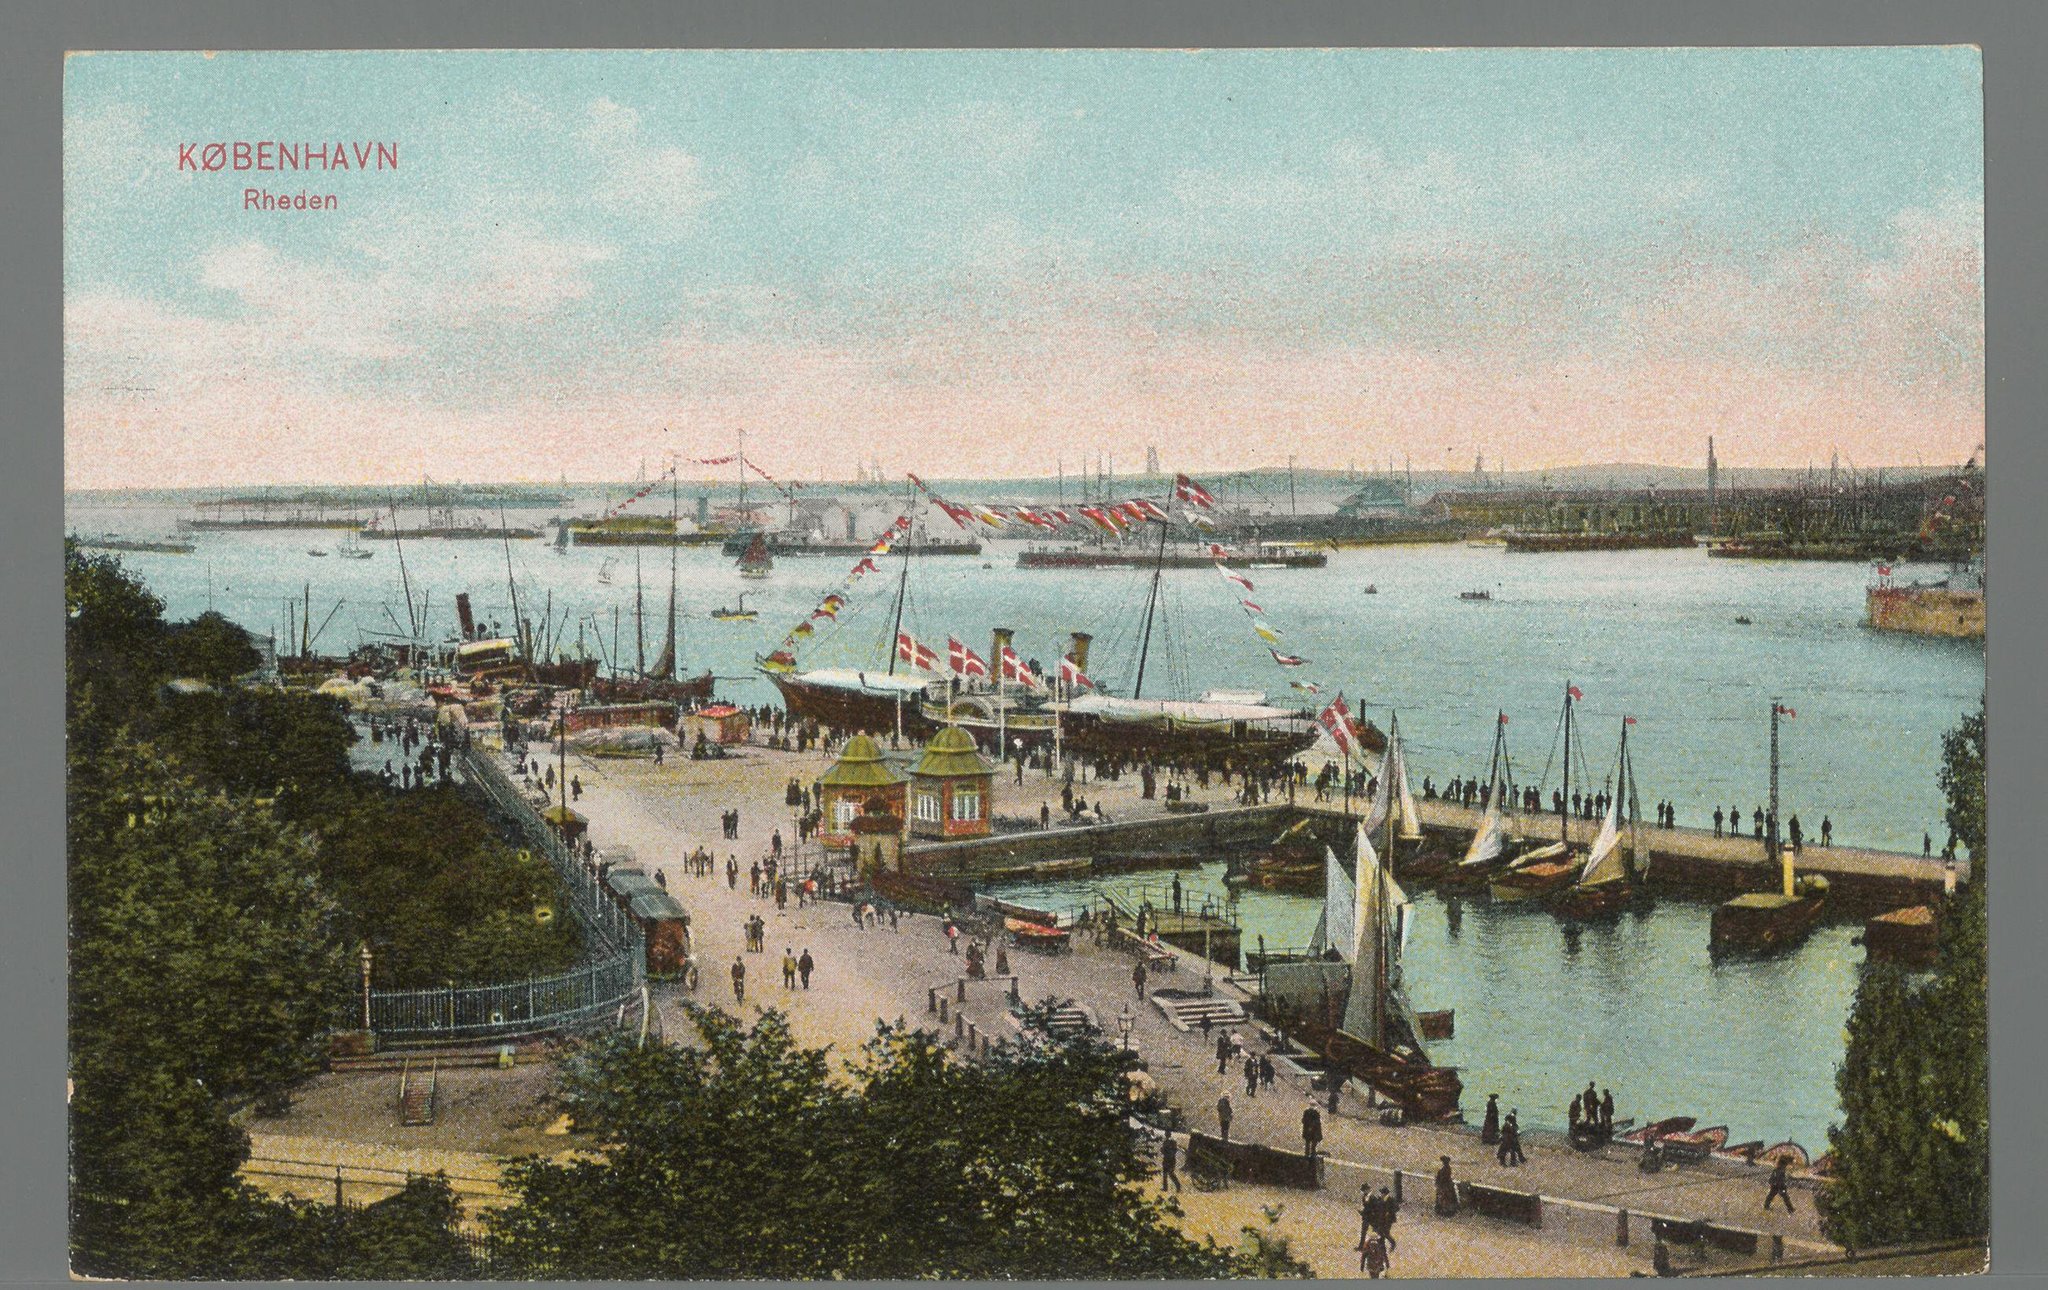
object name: ansichtkaart, prentbriefkaart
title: København. Rheden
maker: Anonymous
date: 1906-1920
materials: cardboard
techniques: lithograph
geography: copenhagen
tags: harbour, city-view, and landscape with man-made constructions (+ city(-scape) with figures, staffage), pier, quay, wharf (+ view ~ vehicle, ship, etc.), copenhagen (city)